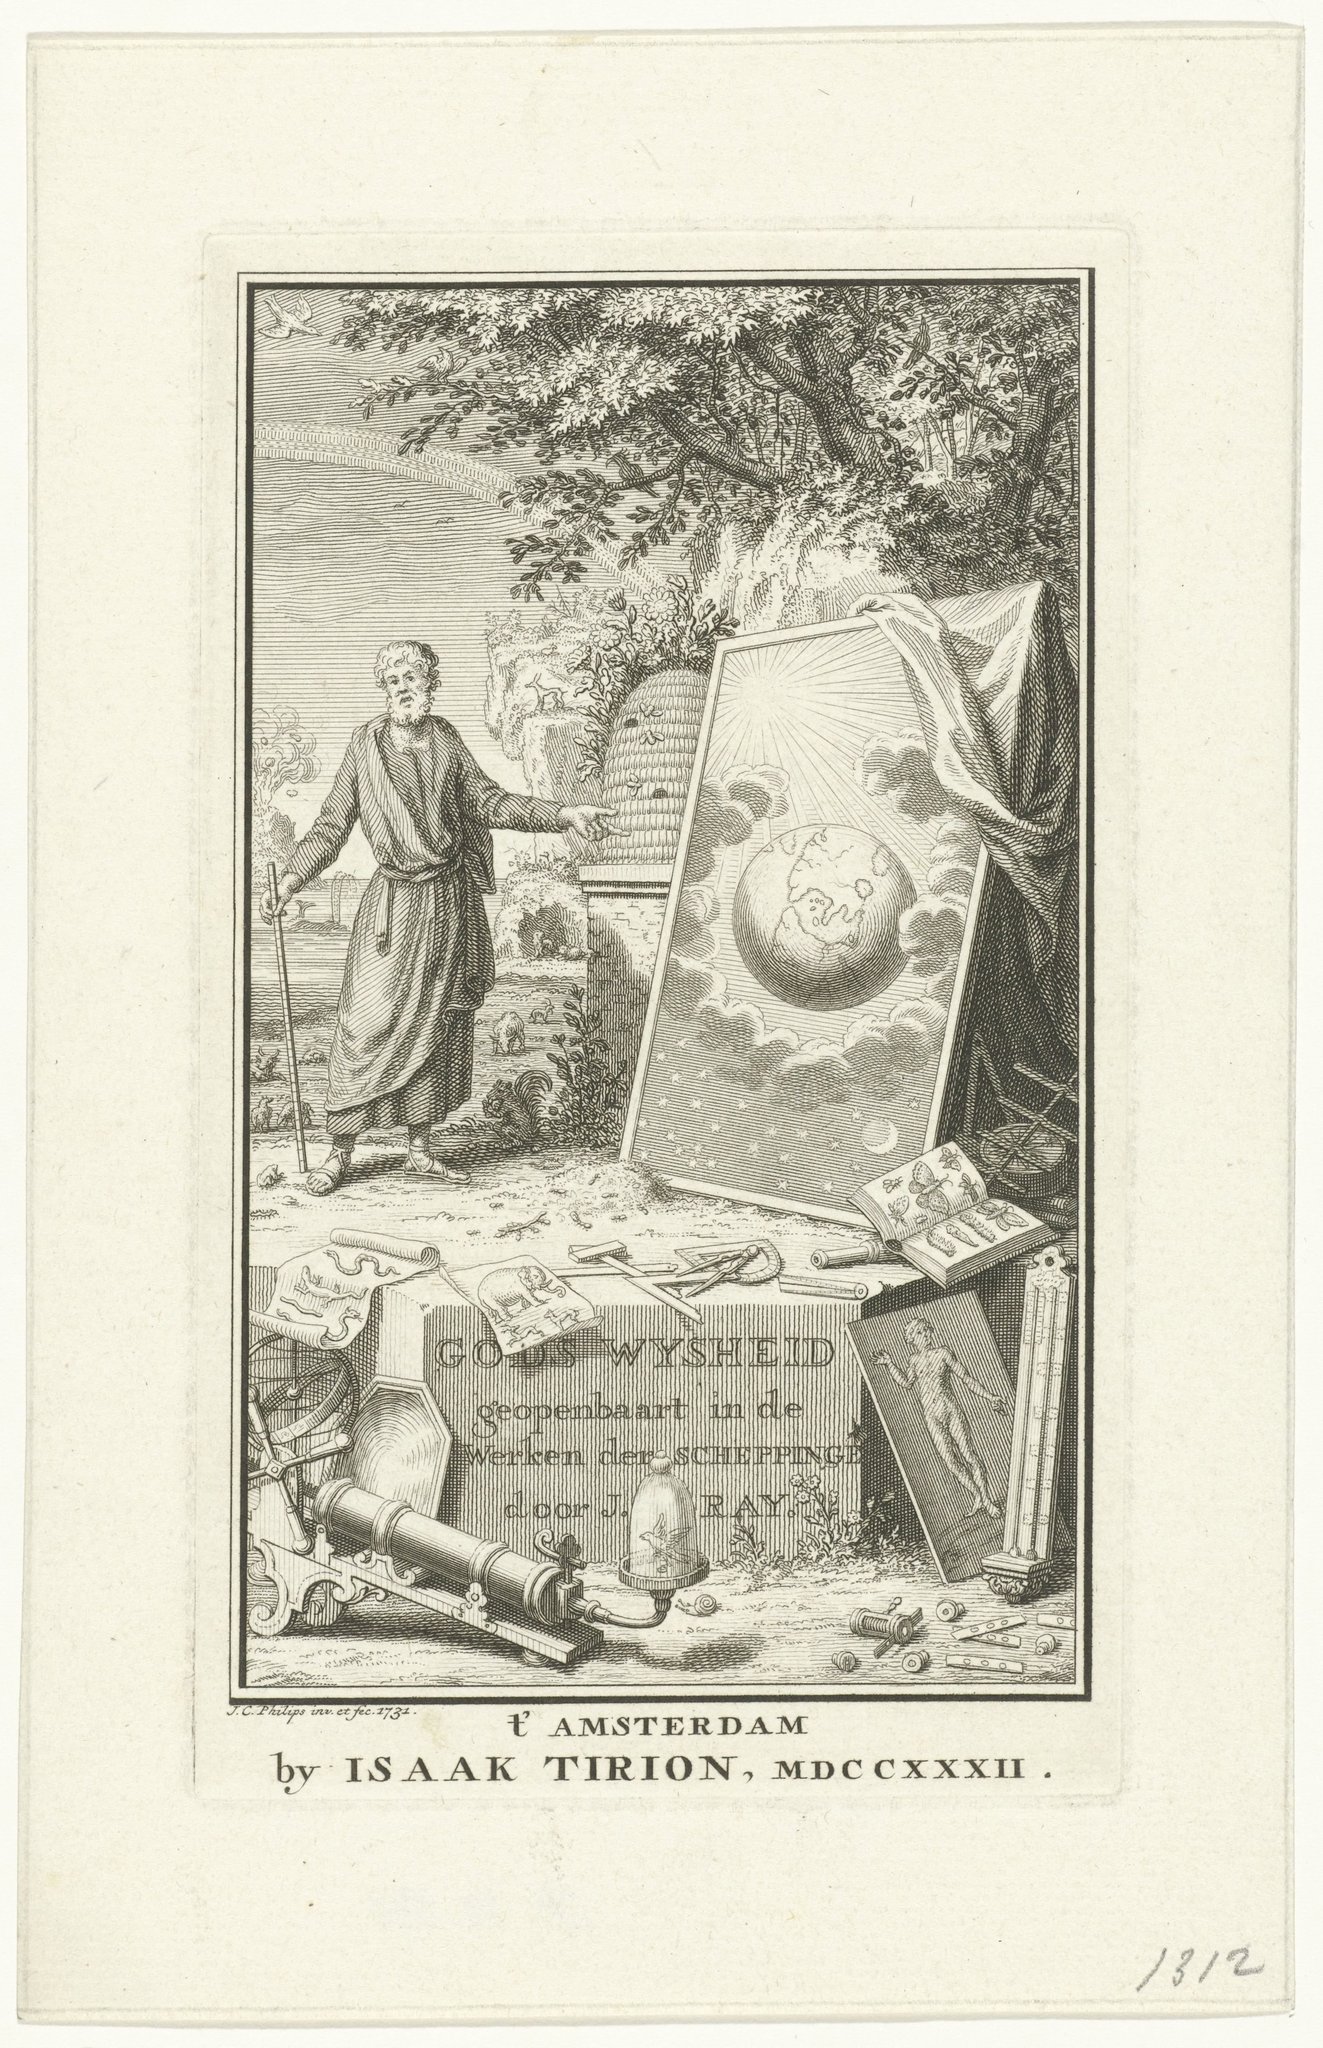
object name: print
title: Titelpagina voor: J. Ray, Gods wysheid geopenbaard in de werken der schepping, 1732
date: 1732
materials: paper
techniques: engraving, etching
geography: amsterdam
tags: honey-comb, creation, the six days of creation (genesis 1:3-25)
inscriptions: collector's mark: Lugt 2228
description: Paradijselijk landschap met een bebaarde man, wijzend op een schilderij waarop de vierde dag van de schepping is voorgesteld: de aardbol te midden van de zon, maan en sterren. Ernaast een bijenkorf, die symbool staat voor vlijtig werken. Op de voorgrond de titel in het Nederlands en diverse attributen die de schepping symboliseren.